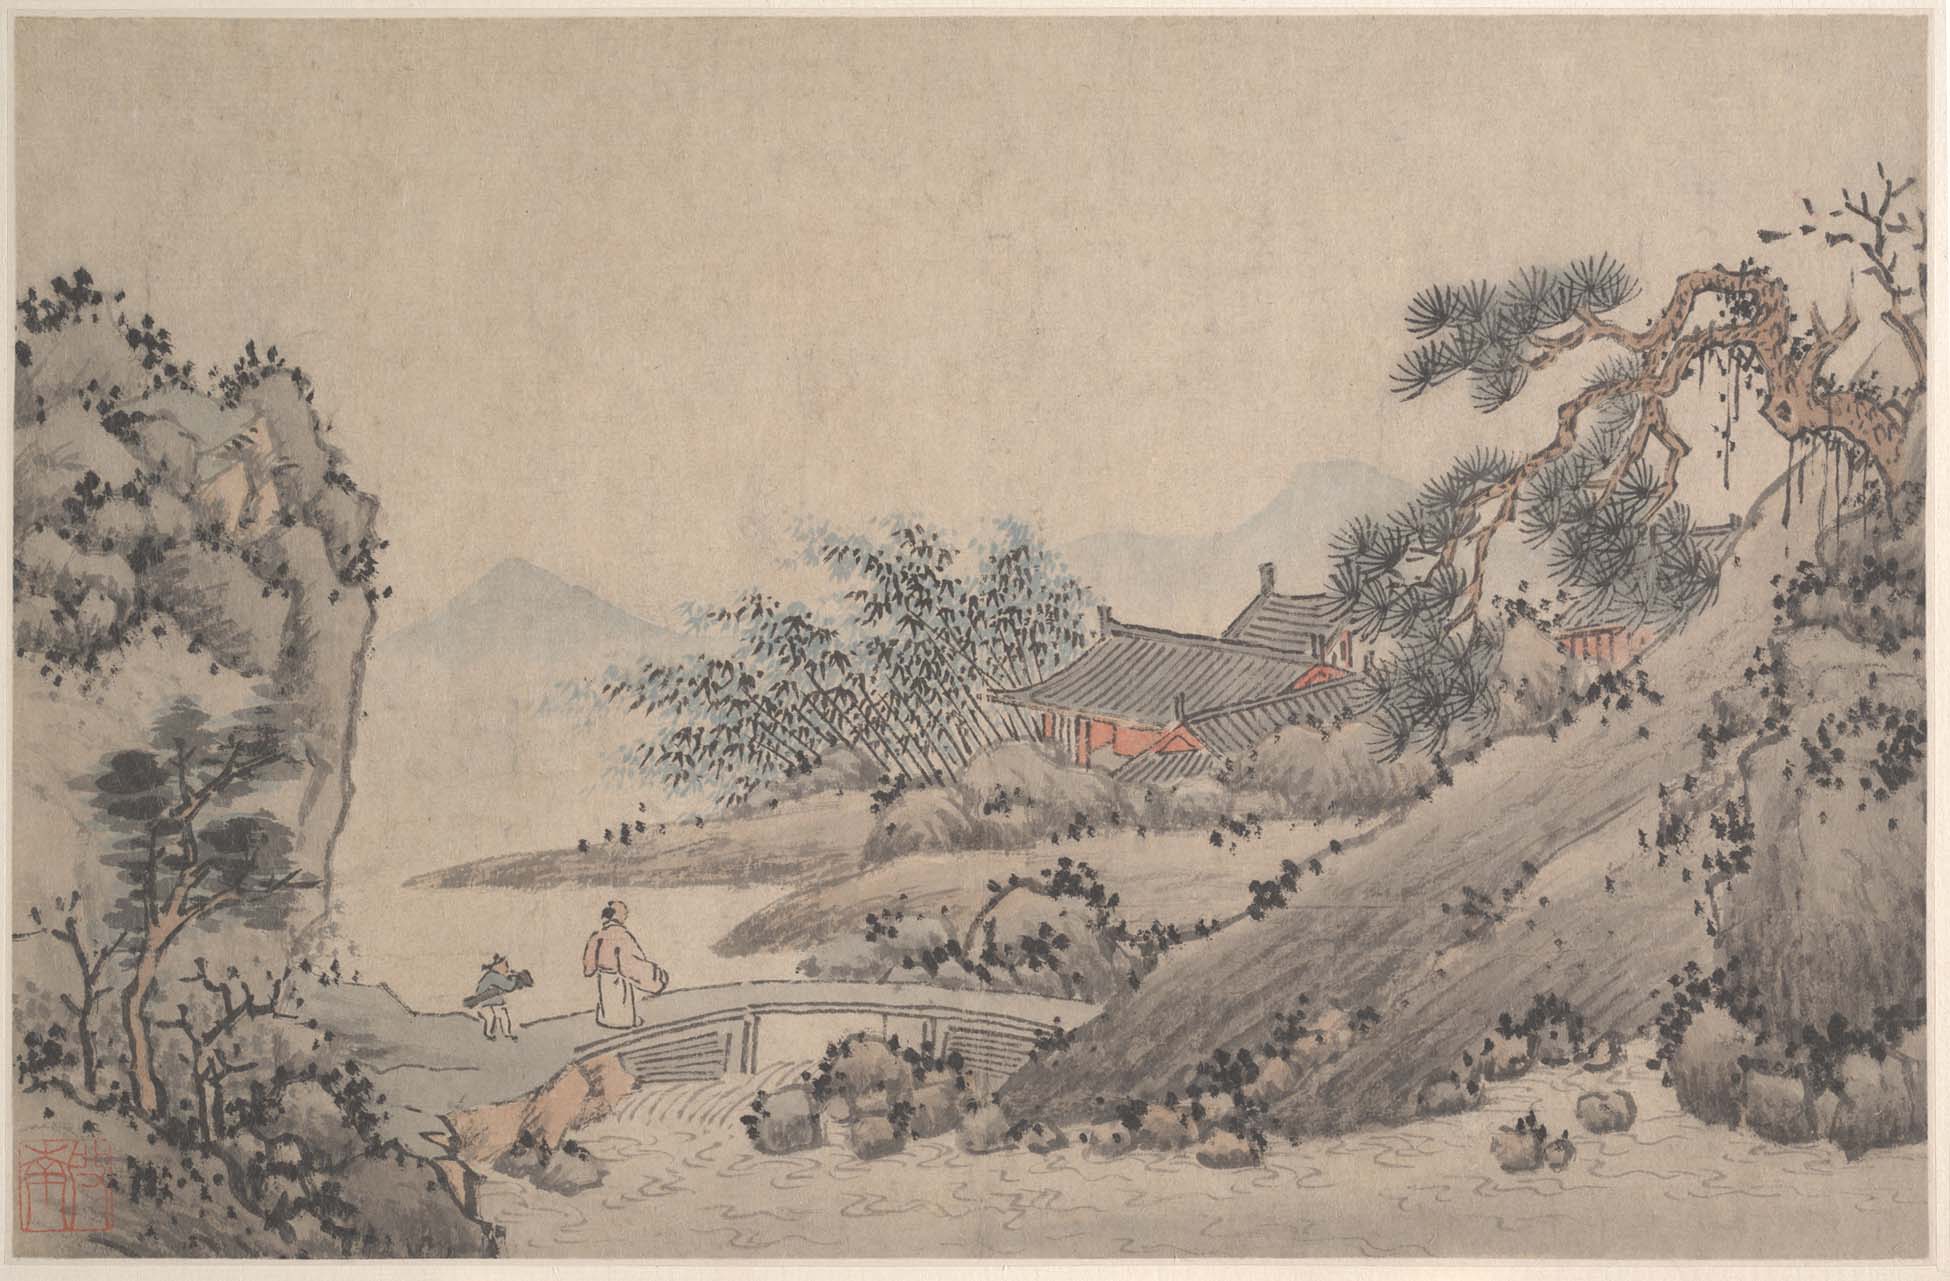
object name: album leaf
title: Landscape with Man Crossing Bridge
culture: chinese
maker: shen zhou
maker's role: artist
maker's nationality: chinese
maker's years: 1427-1509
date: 1427-1509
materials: ink, paper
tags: bridges,men,landscapes